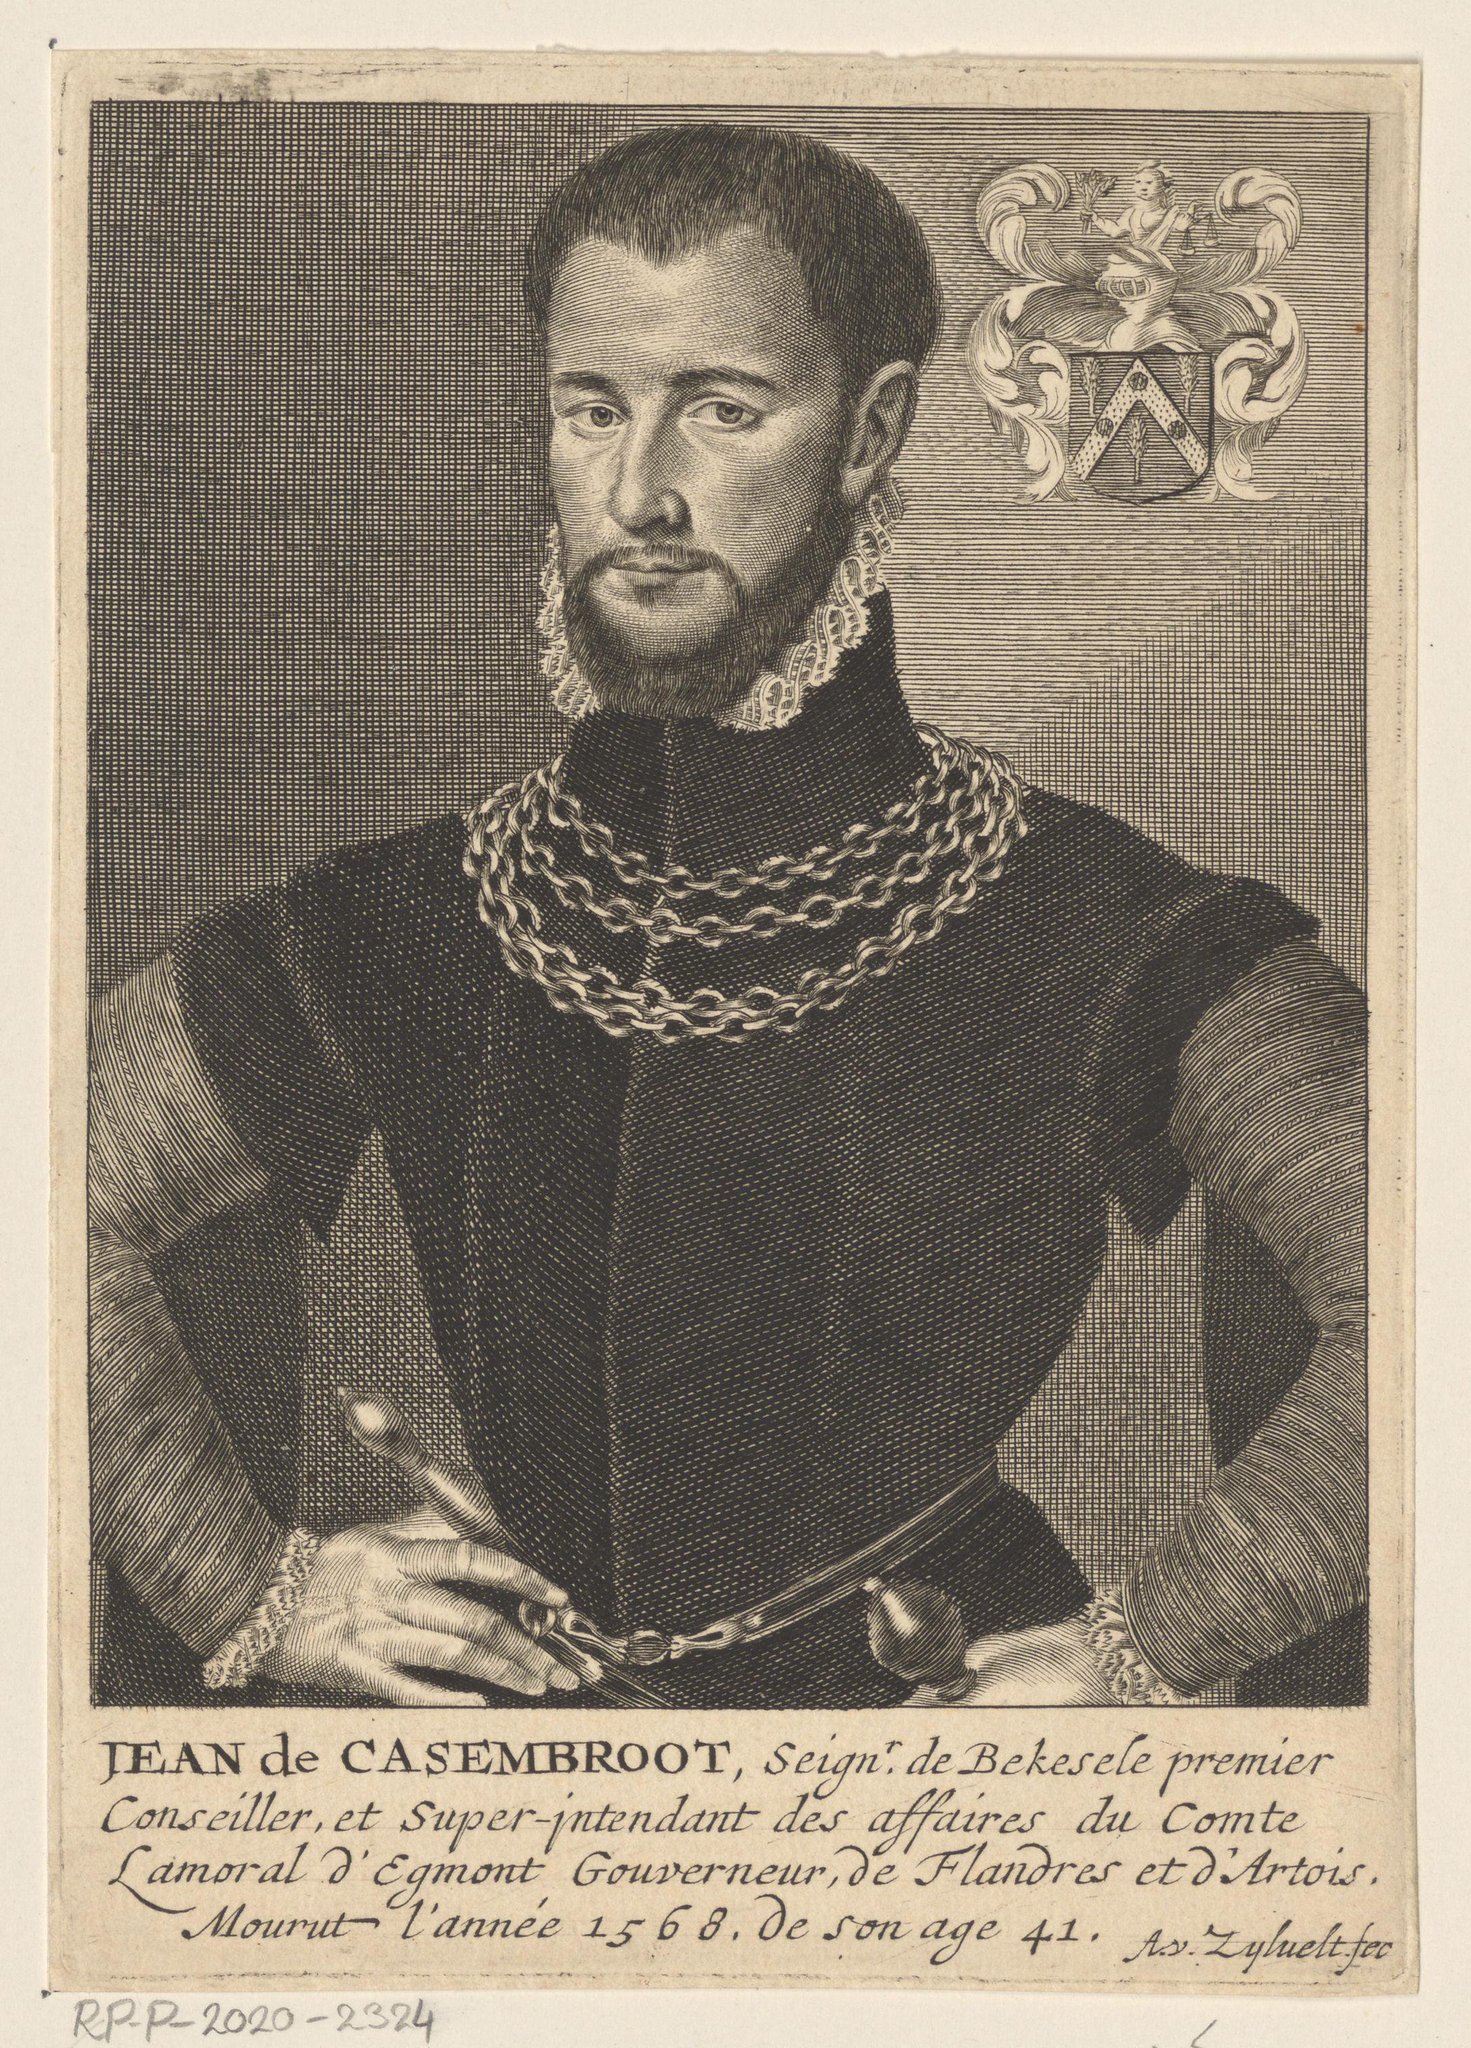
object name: print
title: Portret van Jehan de Casembroot op 41-jarige leeftijd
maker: anthony van zijlvelt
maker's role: print maker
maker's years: 1637-1715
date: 1666-1715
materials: paper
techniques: engraving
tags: historical persons, armorial bearing, heraldry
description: Recht naast het portret het wapenschild van de geportretteerde.